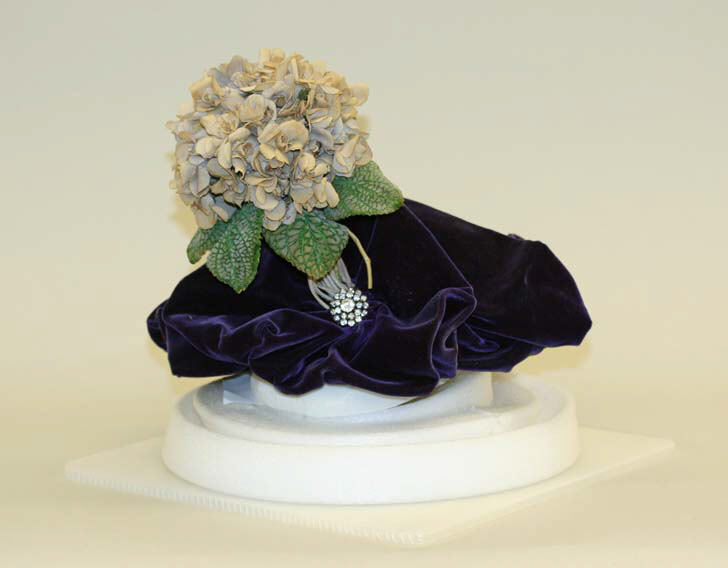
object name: toque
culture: american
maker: stern brothers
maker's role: manufacturer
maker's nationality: american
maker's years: 1867-2001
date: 1898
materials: cotton, glass, silk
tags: flowers